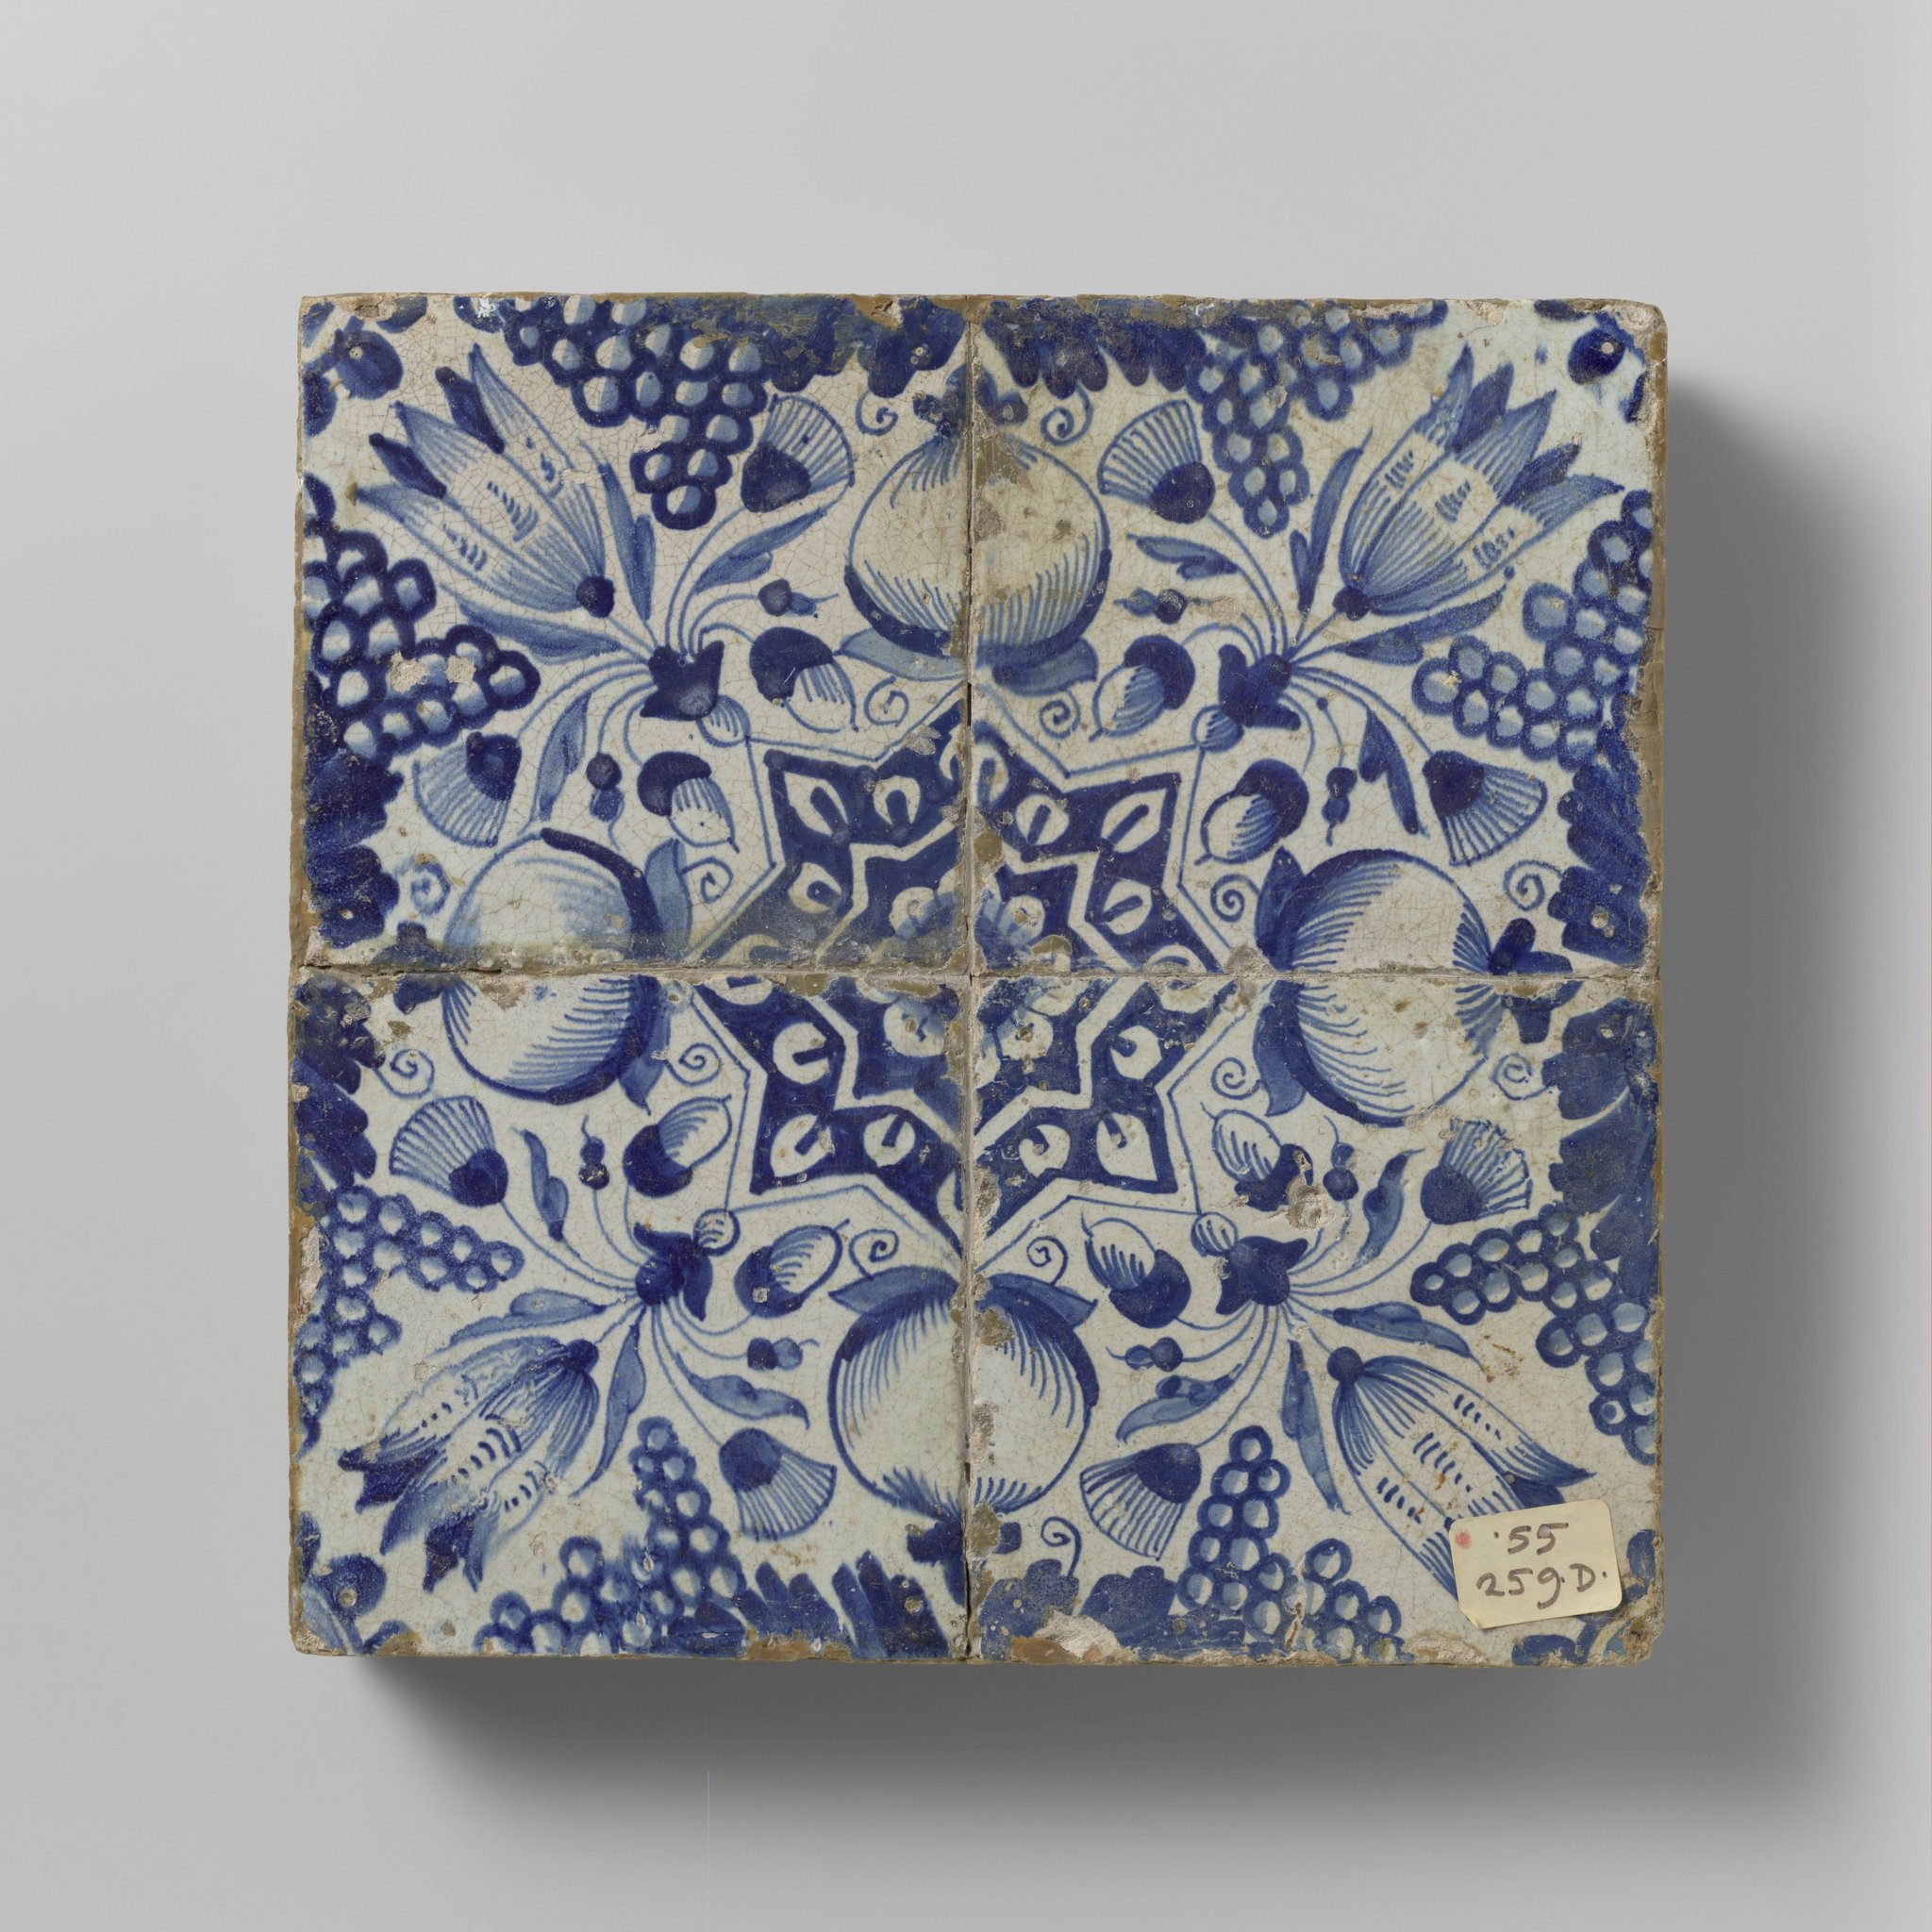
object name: tile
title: Veld van vier tegels met patroon van druiventrossen, granaatappels, tulpen en sterren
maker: Anonymous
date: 1600-1625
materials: earthenware, glaze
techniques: maiolica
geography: netherlands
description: Veld van vier tegels (2 x 2) met een blauw patroon gevormd door vier tegels met granaatappels, druiventrossen en tulpen rond een ster.